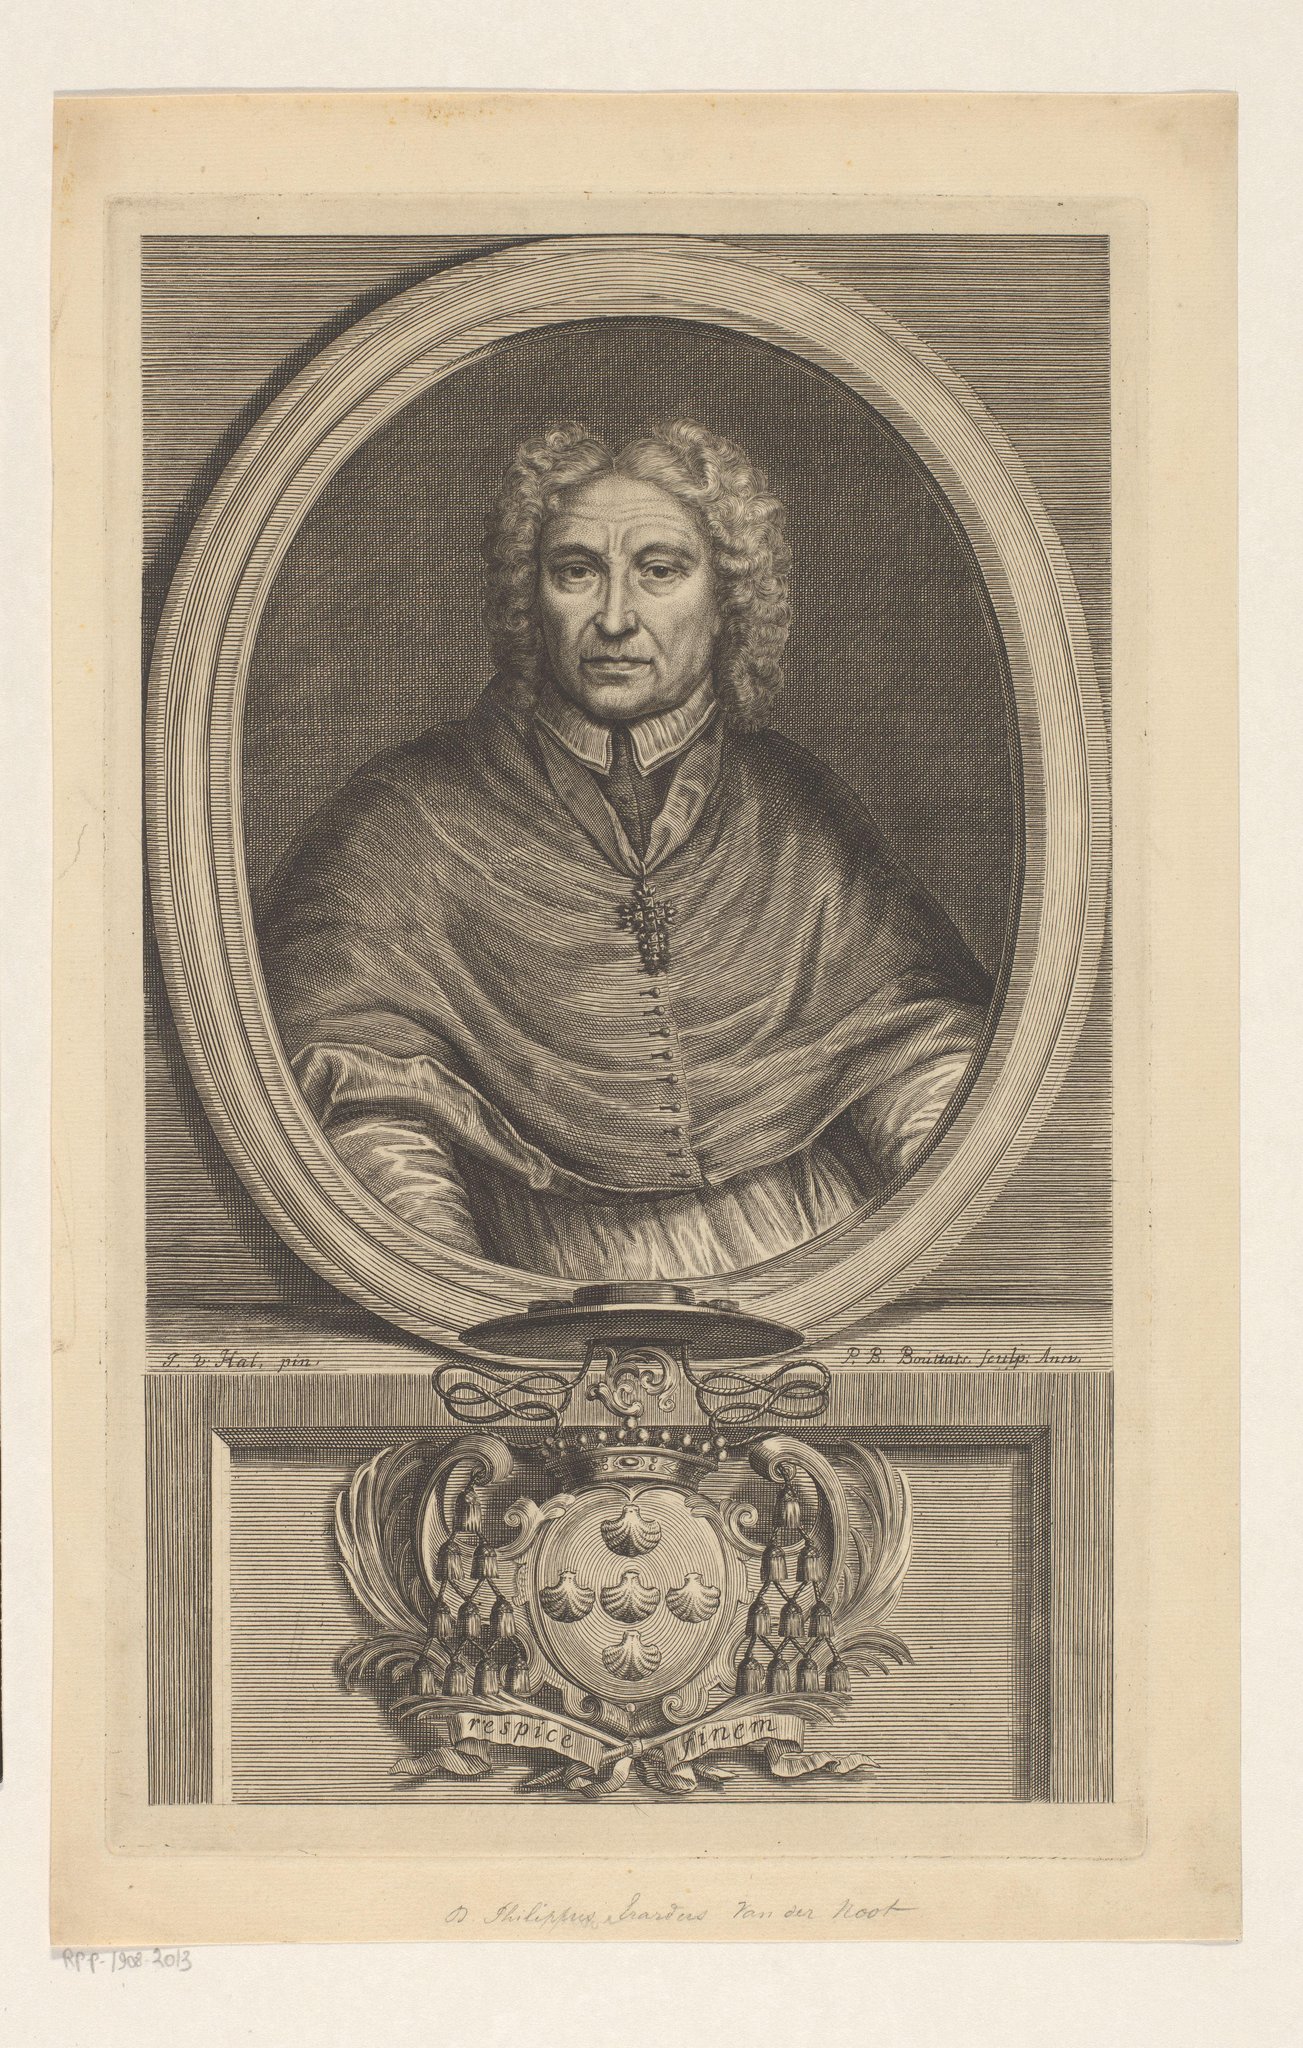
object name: print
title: Portret van Philippus Erard van der Noot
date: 1676-1755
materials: paper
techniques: engraving, etching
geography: antwerp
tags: ghent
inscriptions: collector's mark: Lugt 2228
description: Portret in ovale lijst van Philippus Erard van der Noot, bisschop van Gent. Buste licht naar links. Hij draagt het bisschopsgewaad. Middenonder het wapenschild van de bisschop en de kardinaalshoed.